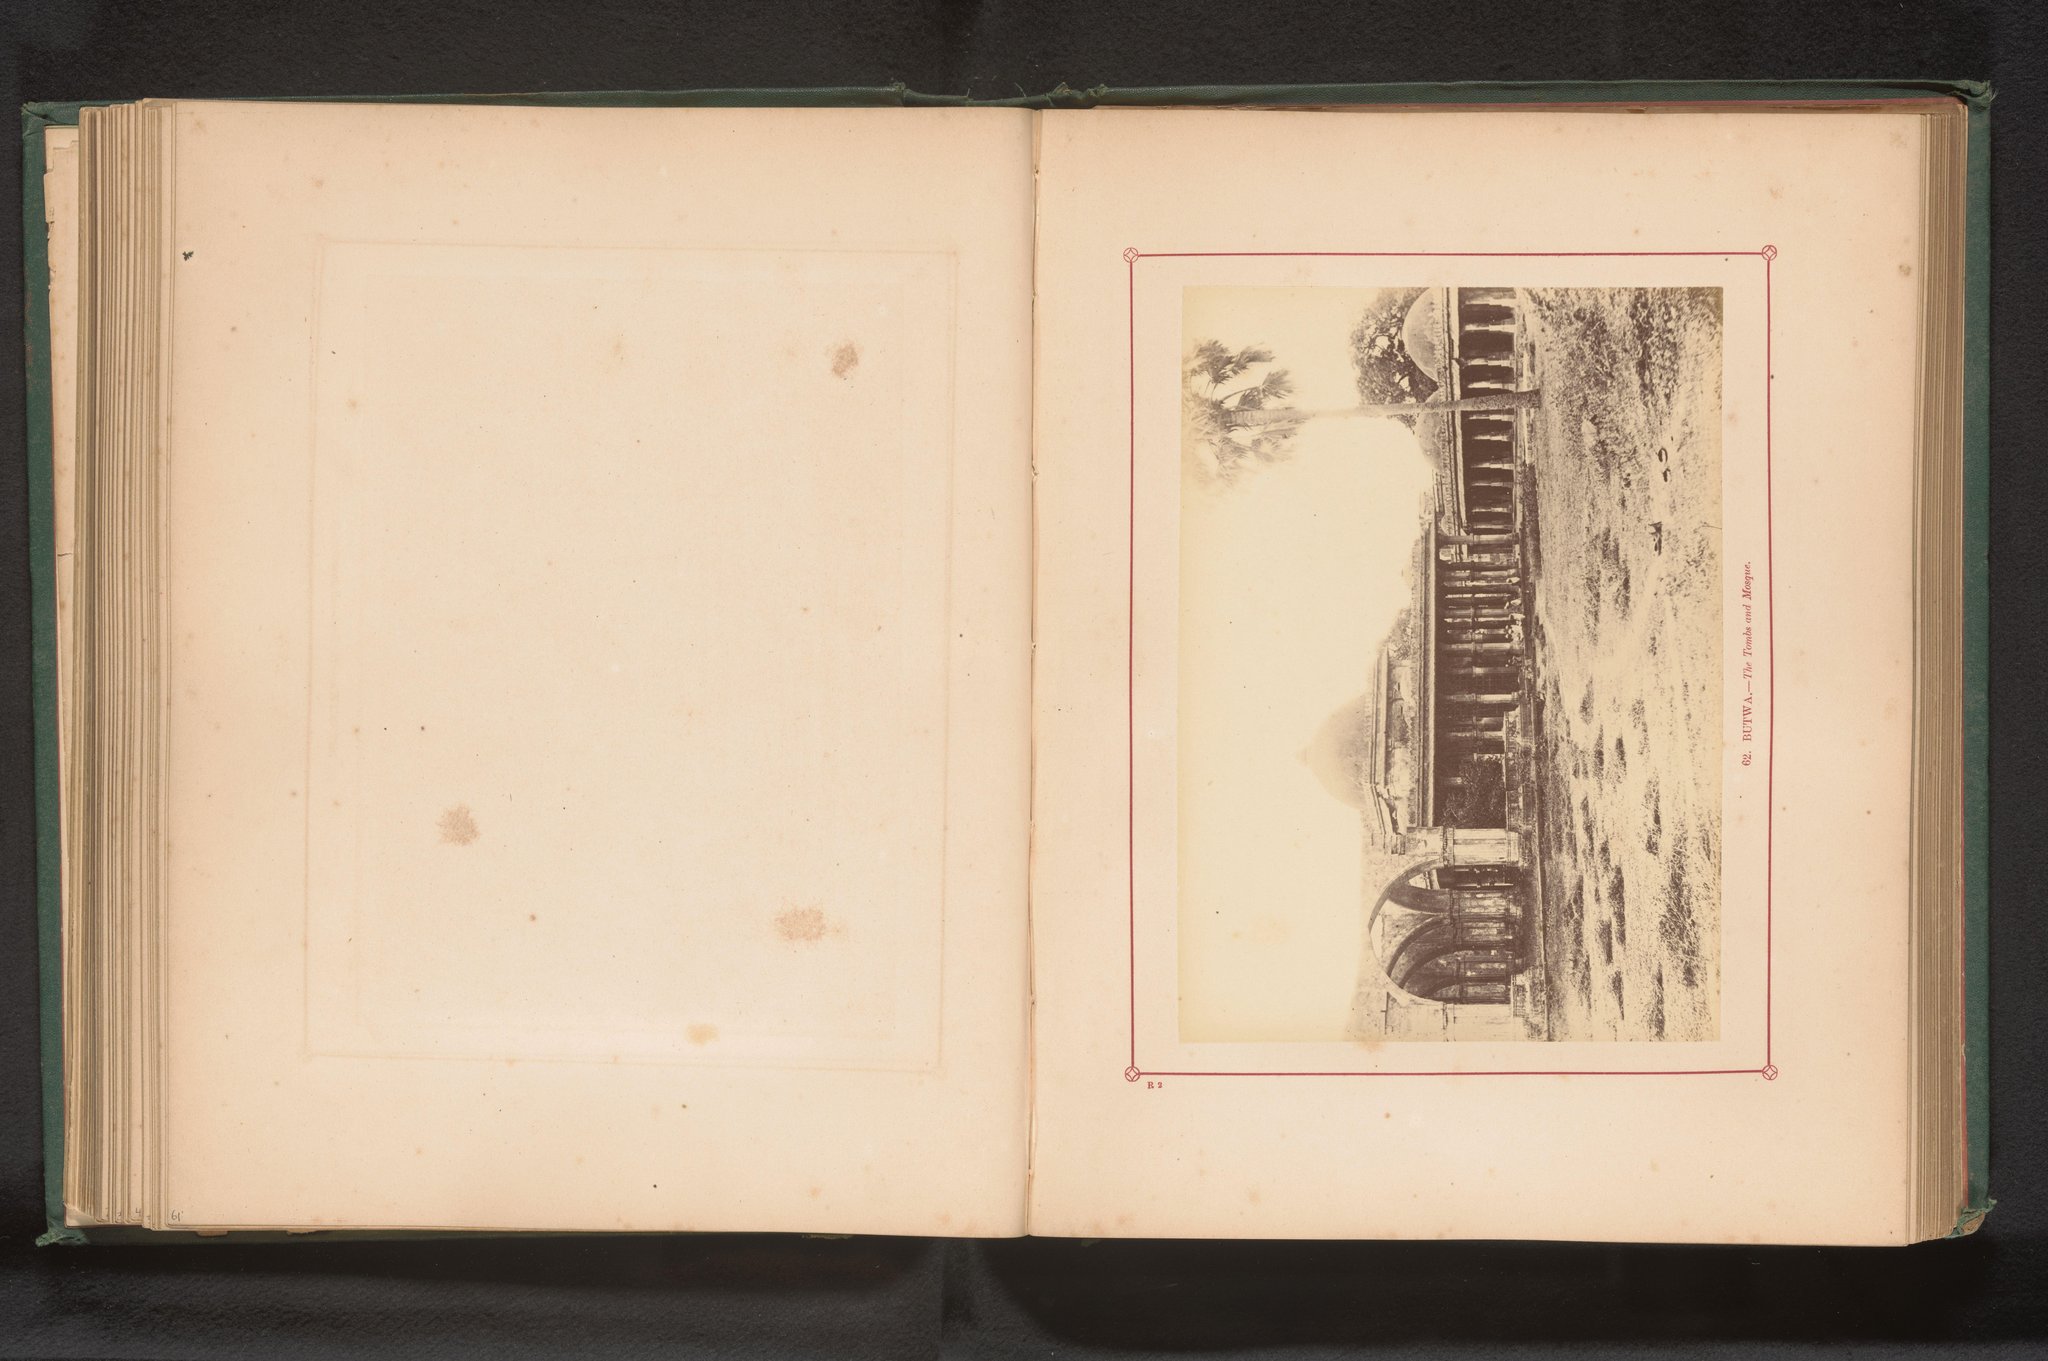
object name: page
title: Butwa.- The Tombs and Mosque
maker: thomas biggs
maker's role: fotograaf, kapitein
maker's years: 1822-1905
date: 1856-1866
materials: photographic support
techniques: albumen print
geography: ahmedabad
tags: grave, tomb, temple, shrine ~ islam, mohammedanism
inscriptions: number: ‘62.’, inscription: ‘R2’